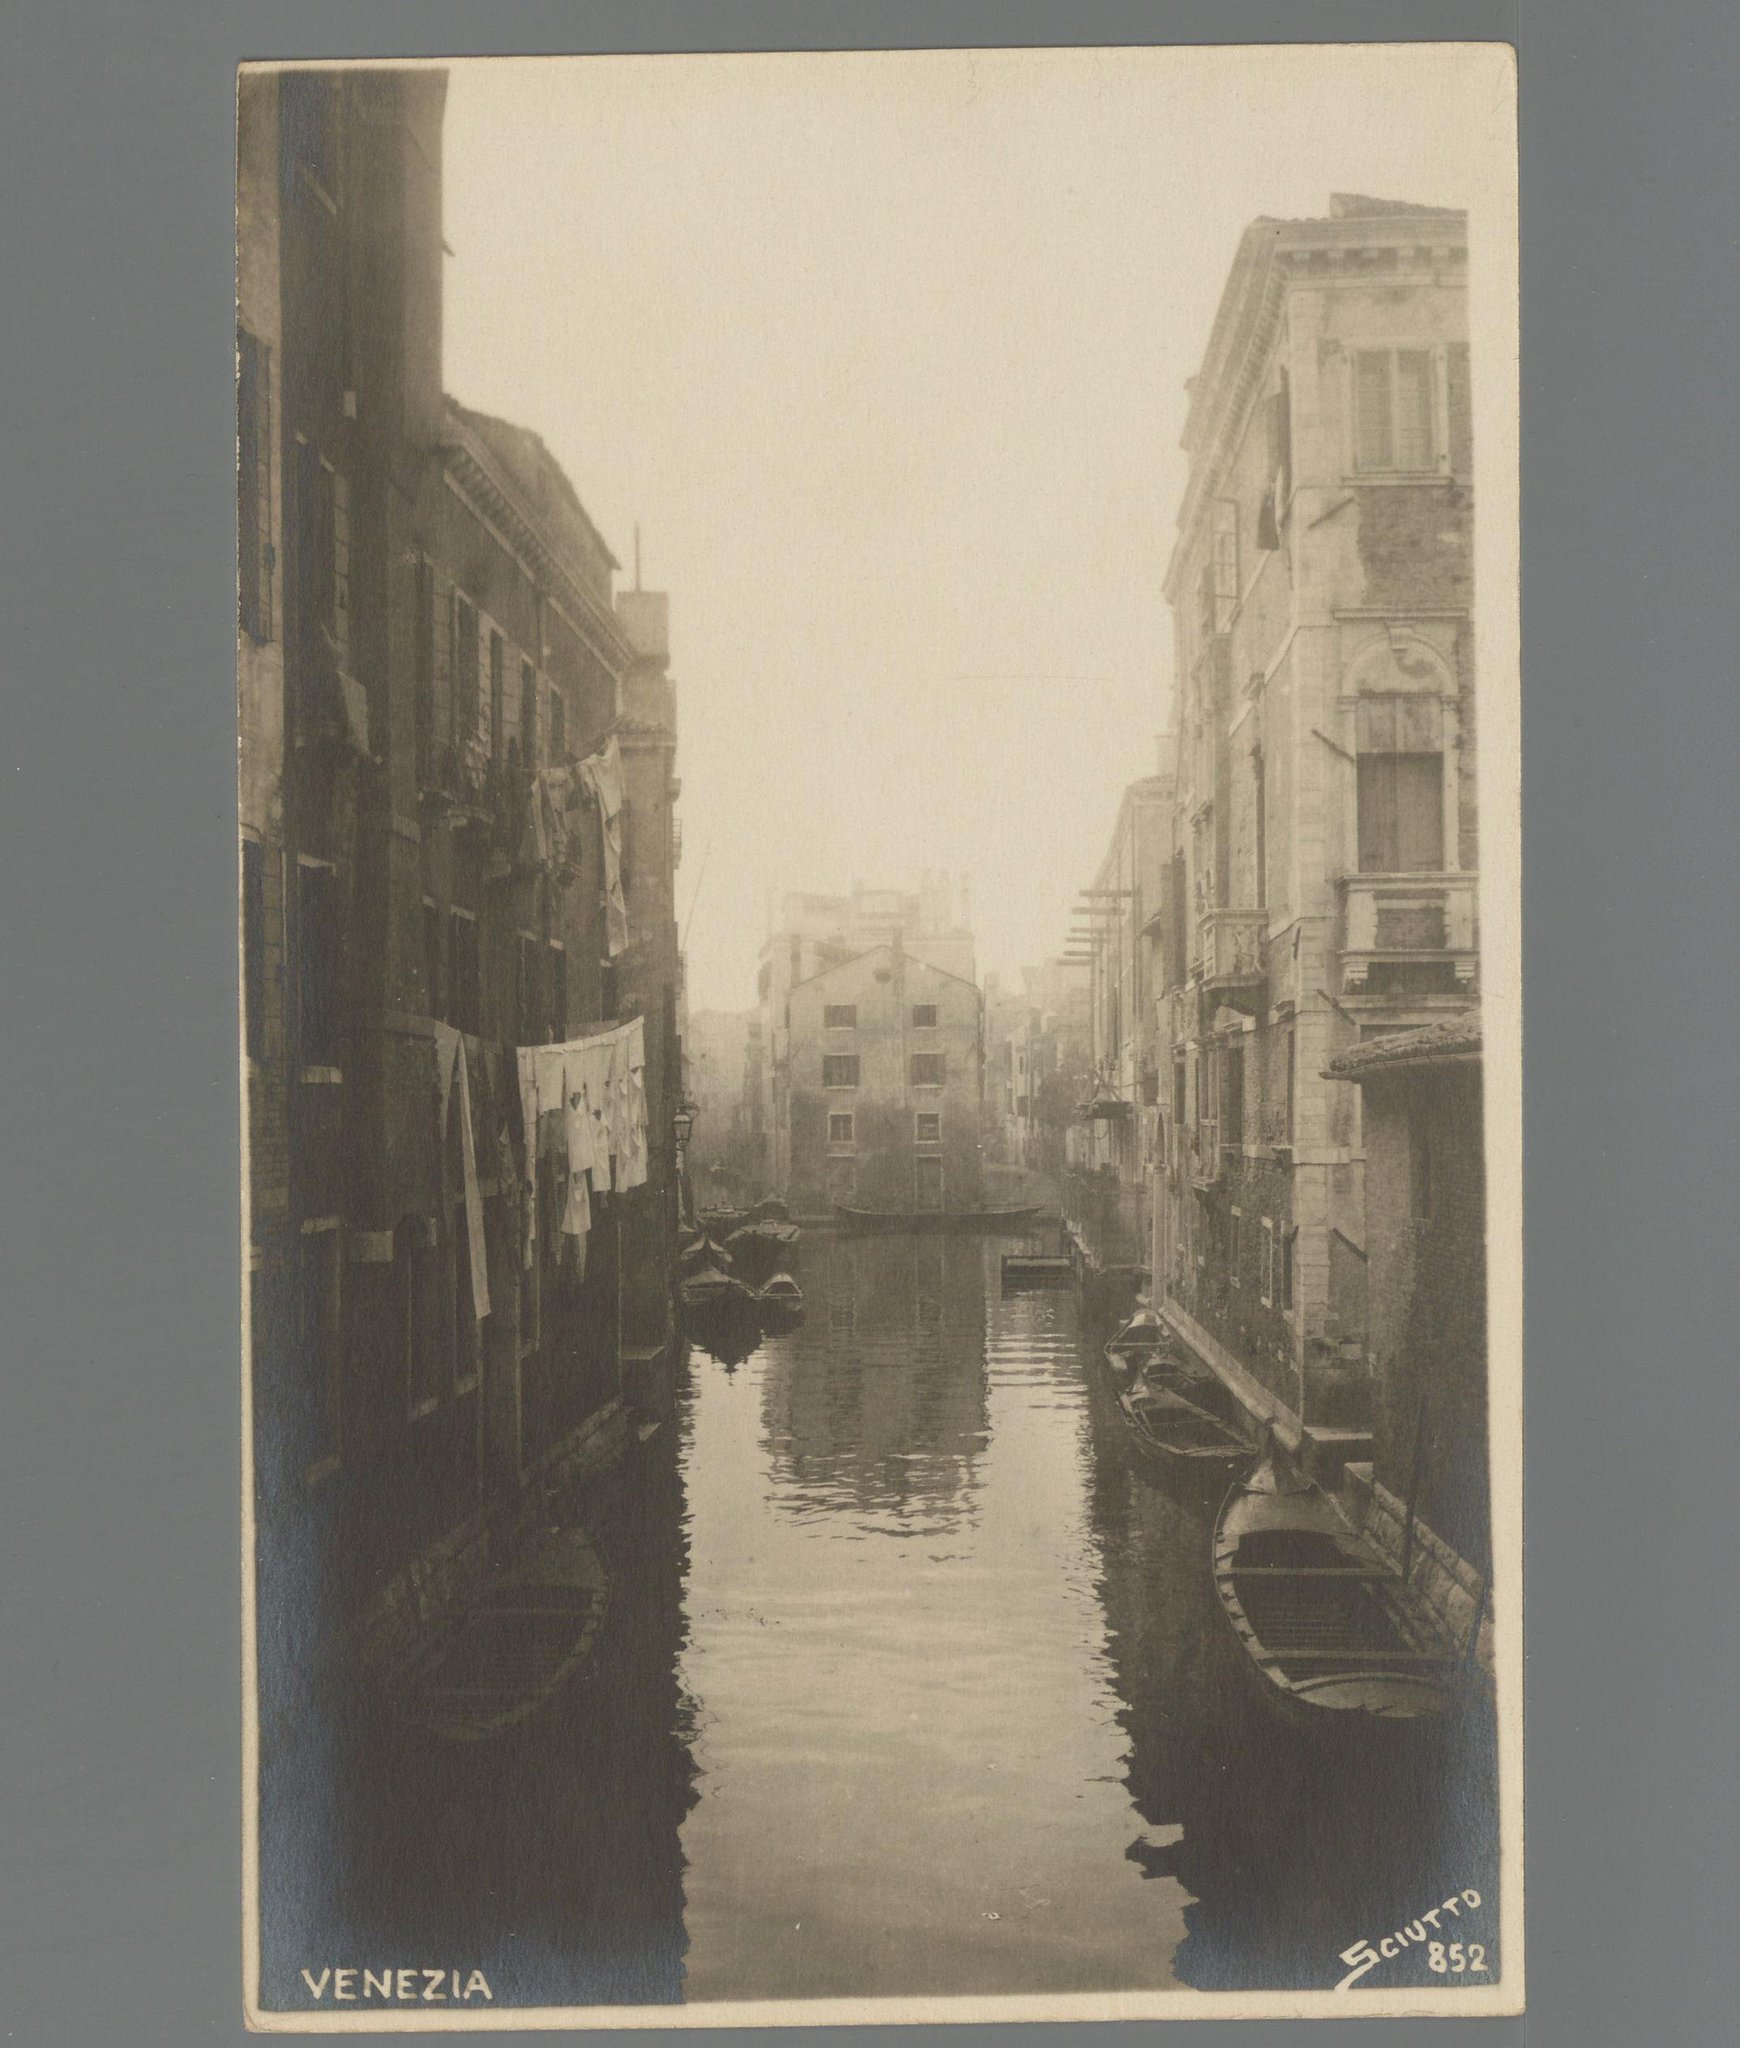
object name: ansichtkaart, prentbriefkaart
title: Venezia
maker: tensi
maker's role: publisher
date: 1906-1920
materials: photographic support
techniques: photography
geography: italy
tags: city-view, and landscape with man-made constructions, ships (in general) - cc - more than one ship, venice